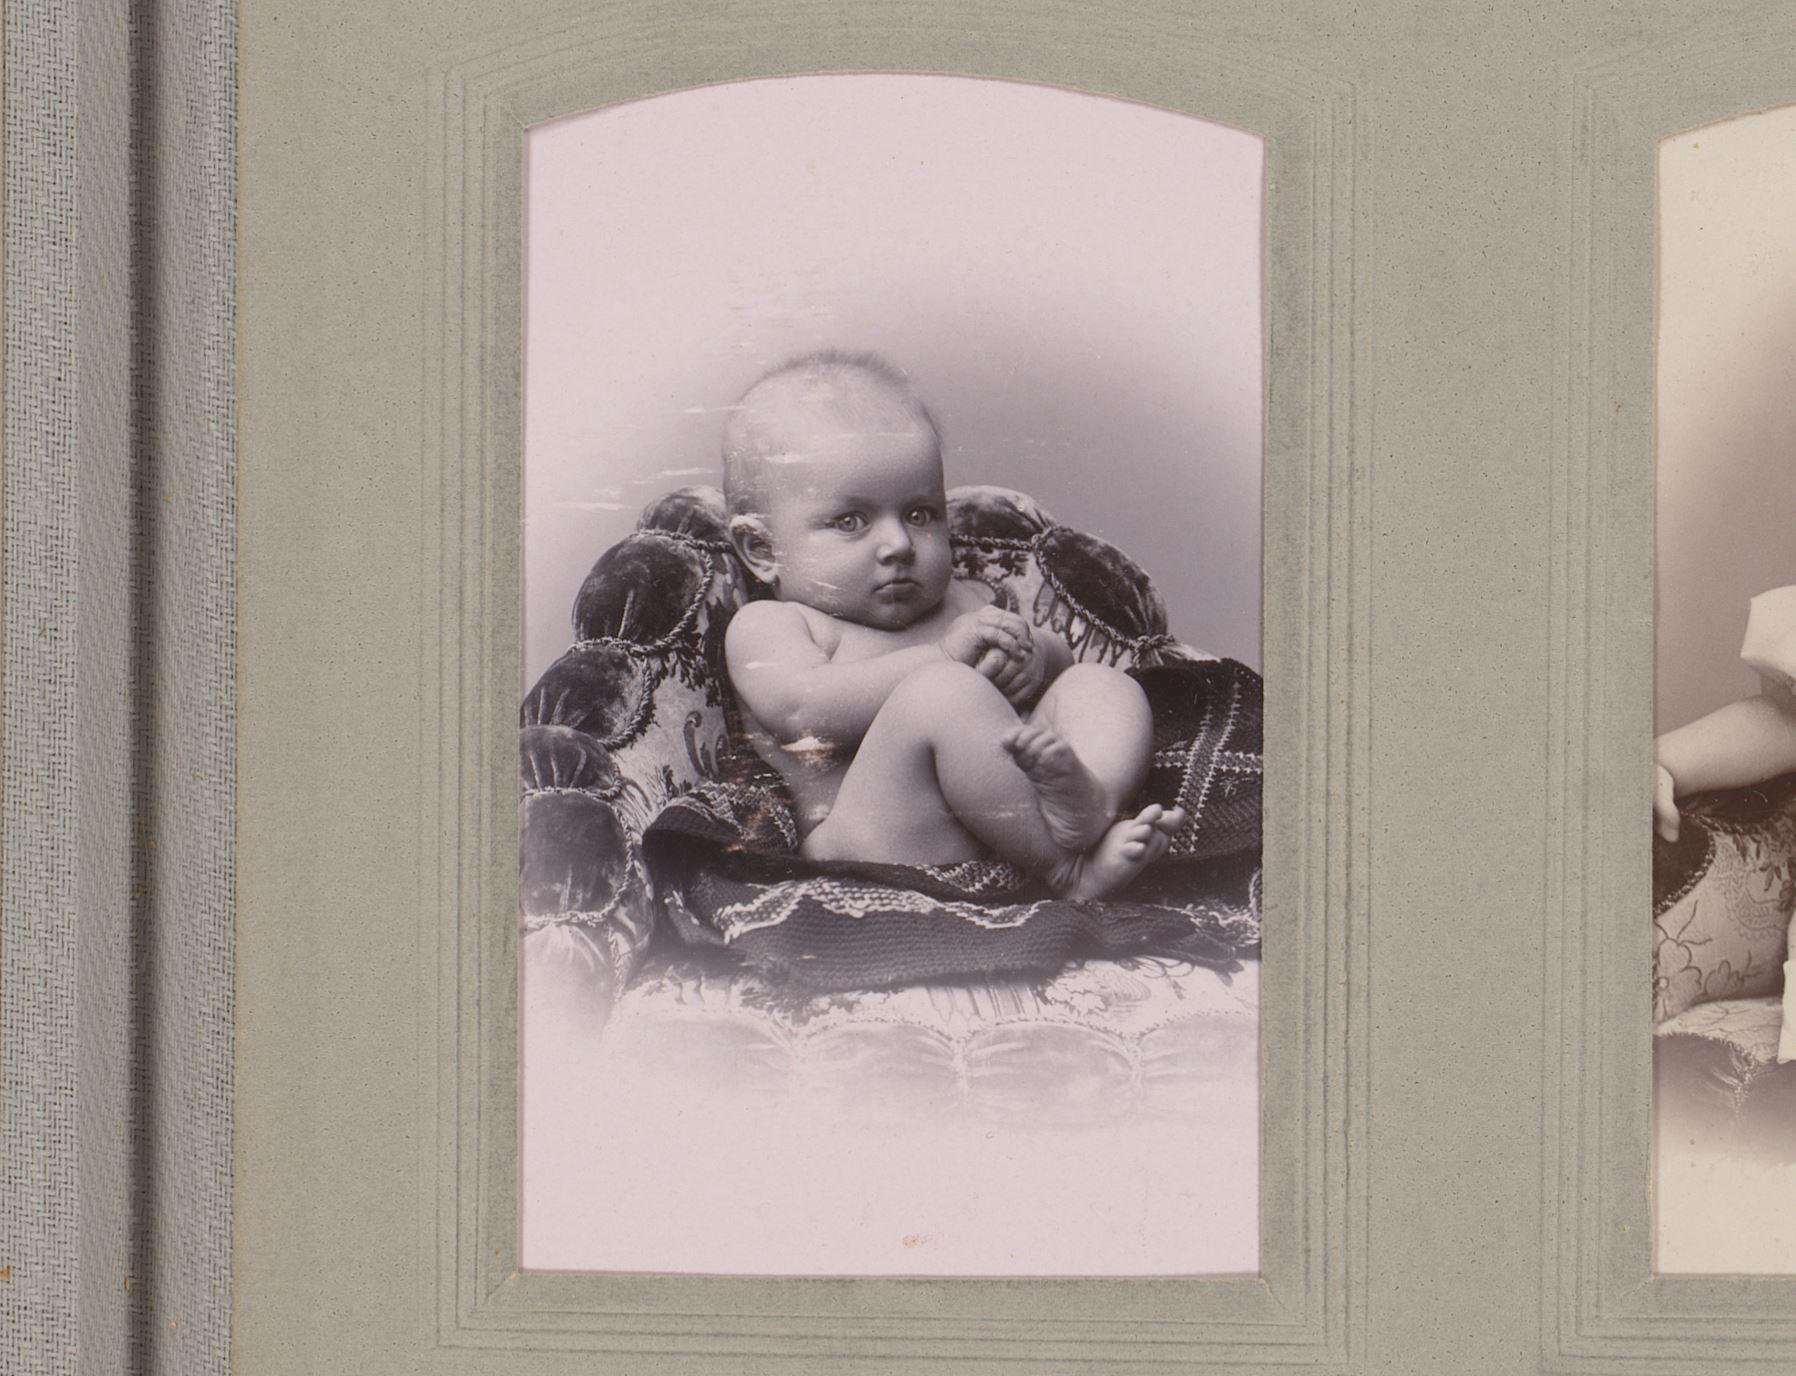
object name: photograph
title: Portret van een zittende baby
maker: frans g. klemming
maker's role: fotograaf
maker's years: 1859-1922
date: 1880-1922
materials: cardboard, photographic support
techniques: collodion silver print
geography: stockholm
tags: sitting figure, historical persons, infant, baby ~ the ages of man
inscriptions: inscription: ‘Allm. Telefon 62 61./ Fr. G. Klemming/ Stockholm/ 38 Hamngatan 38.’